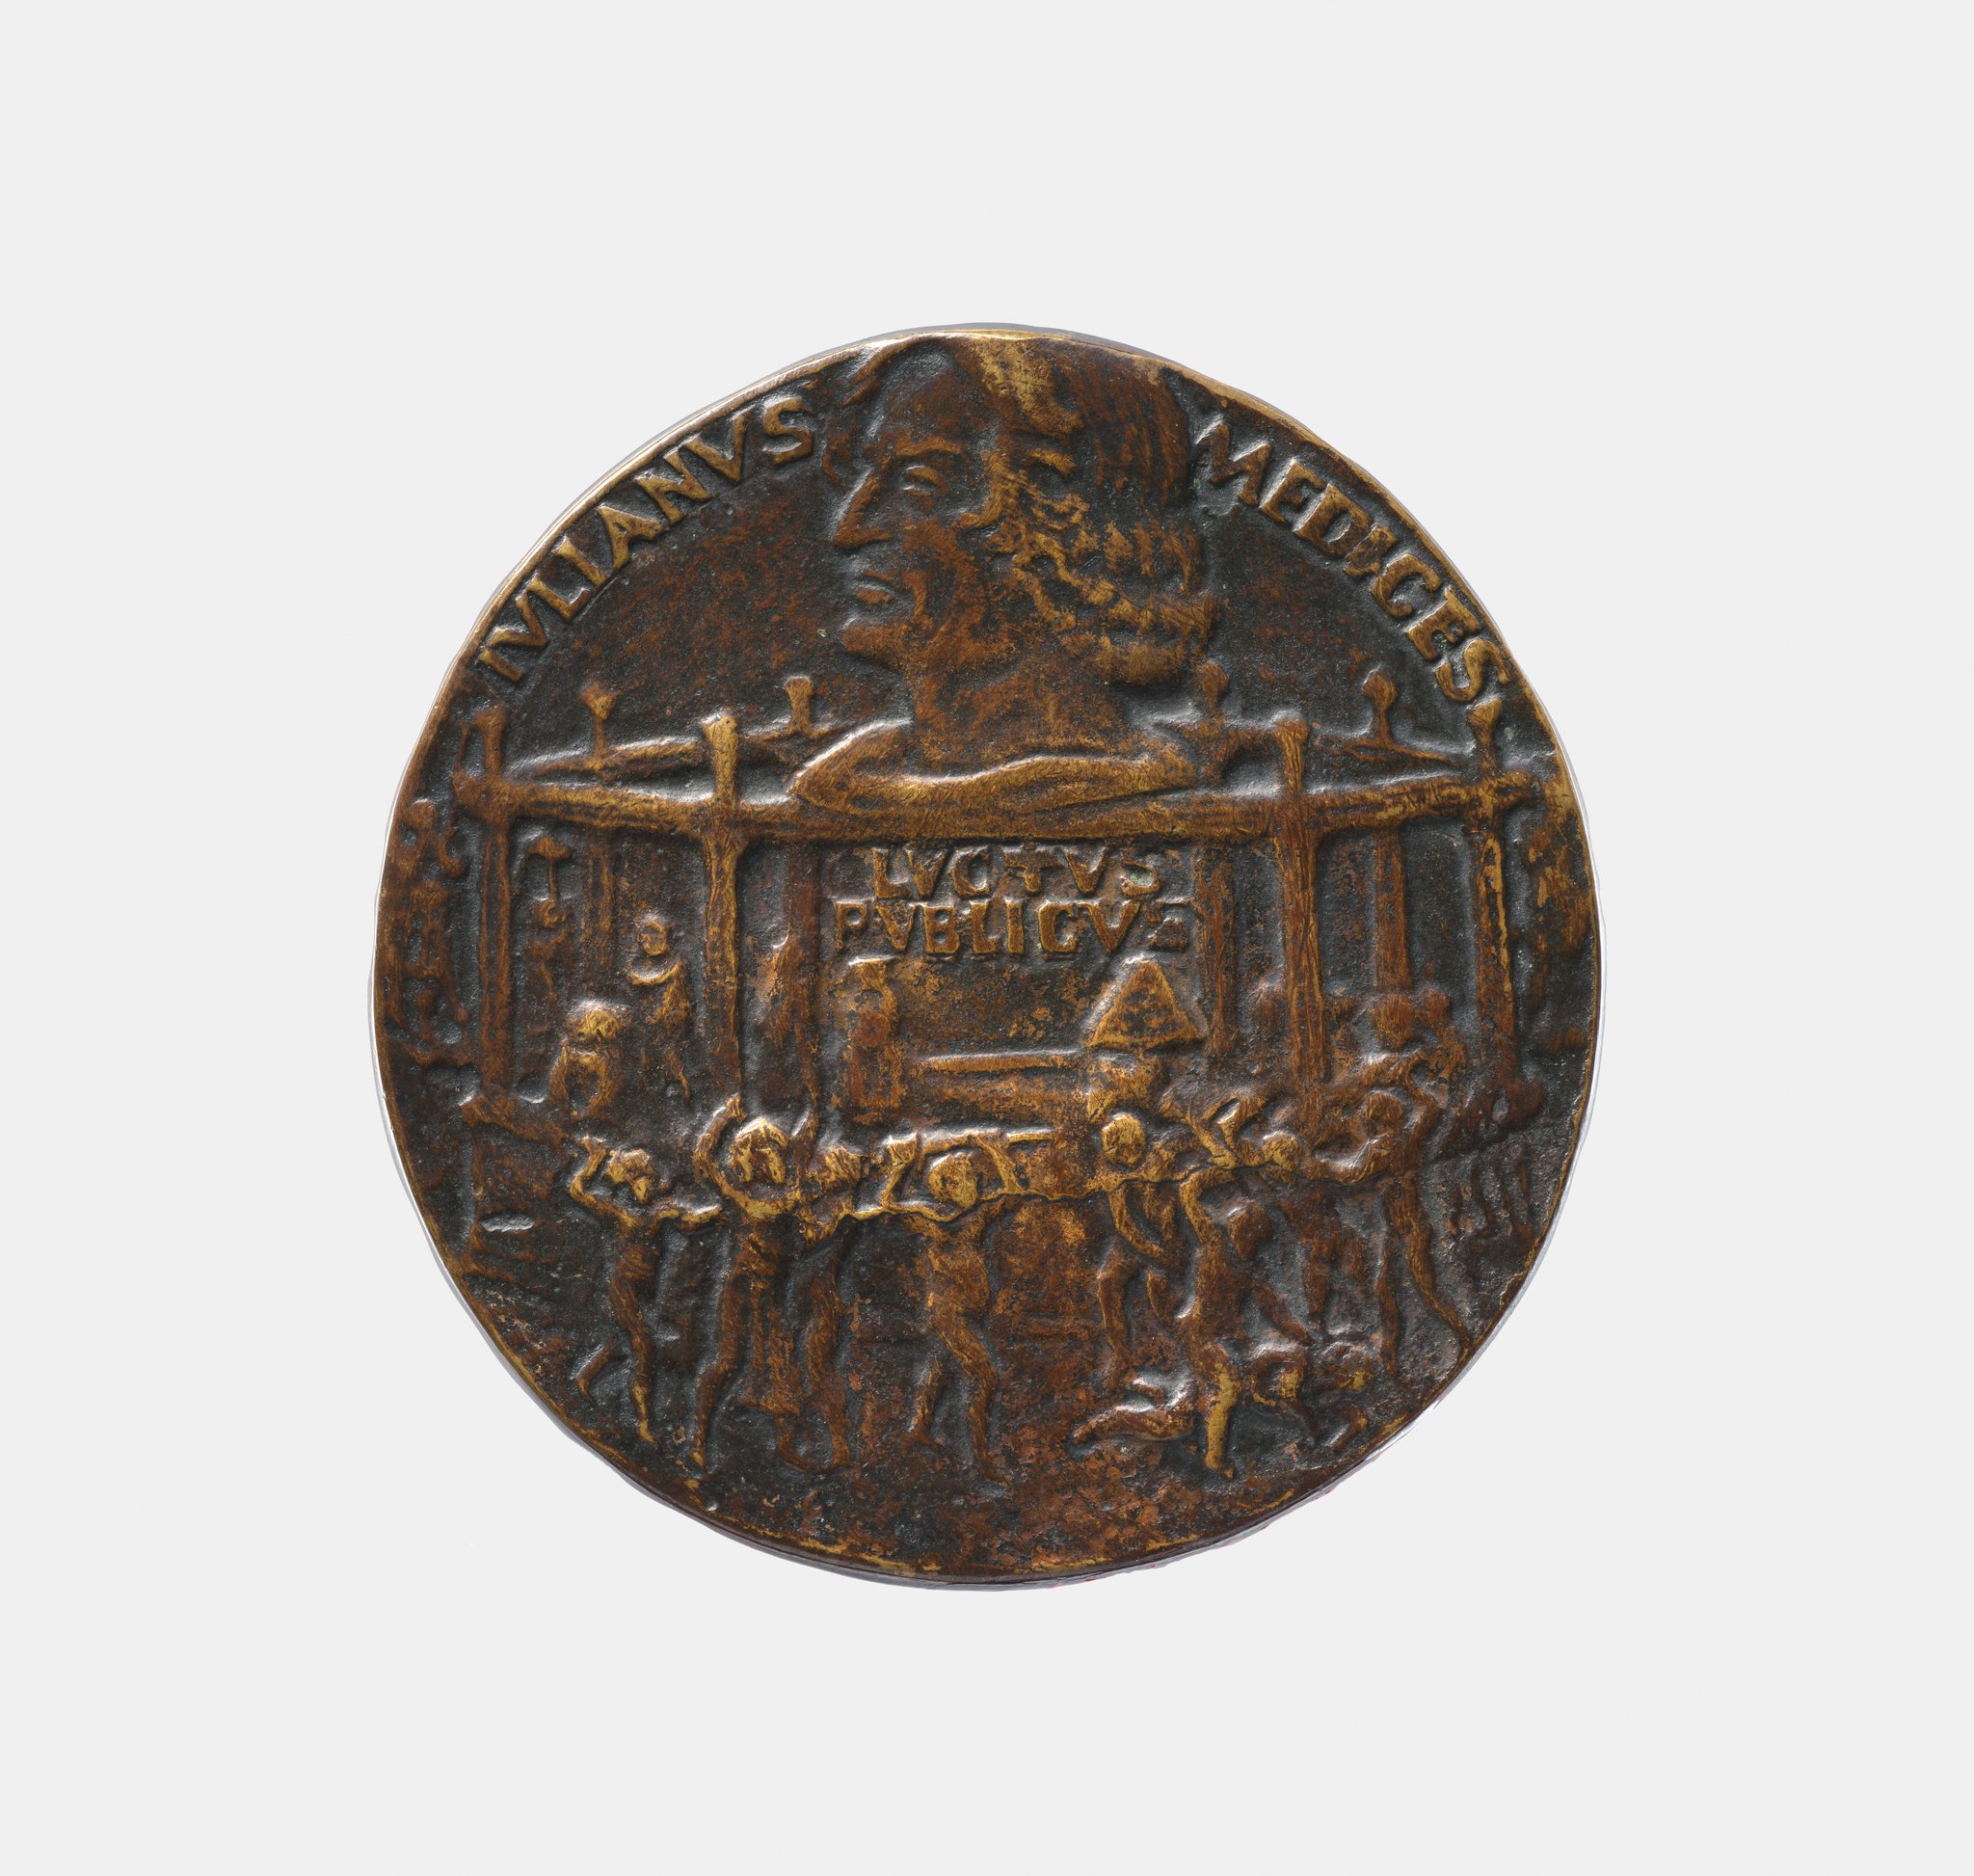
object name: medal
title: To Commemorate the Pazzi Conspiracy, 1478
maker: bertoldo di giovanni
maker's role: artist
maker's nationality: italian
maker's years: 1430-1491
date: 1478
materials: bronze